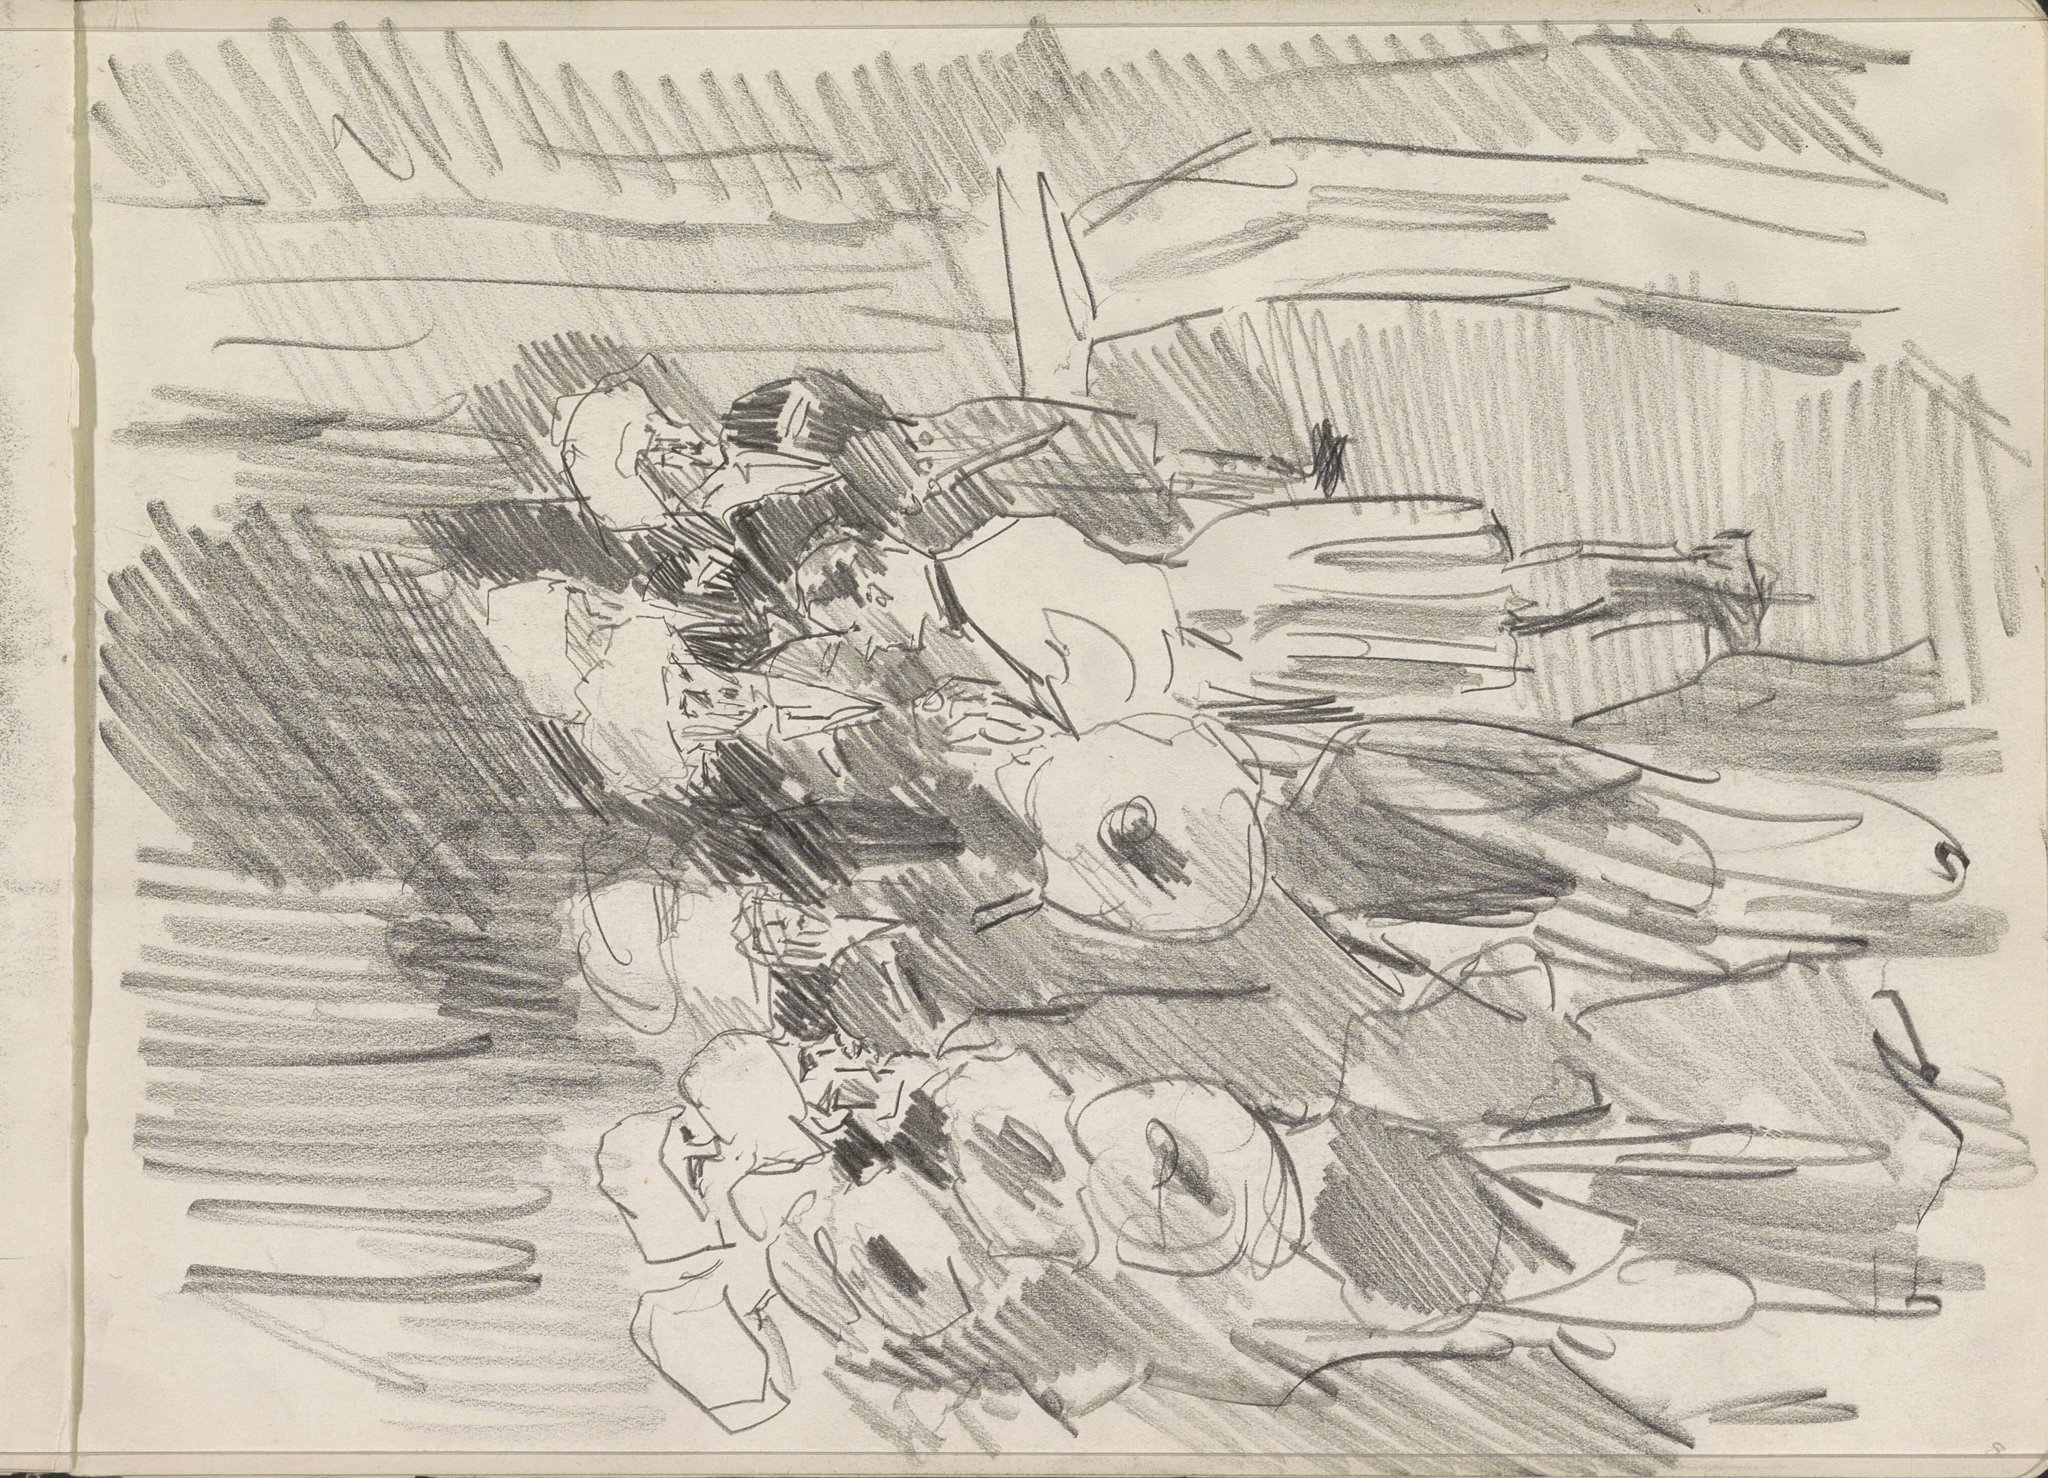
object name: sketchbook leaf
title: Kozakkenkoor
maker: isaac israels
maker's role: draughtsman, painter, print maker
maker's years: 1865-1934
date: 1875-1934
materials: paper, pencil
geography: the hague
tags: choir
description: Met dirigent. Blad 8 recto uit schetsboek V met 33 bladen.